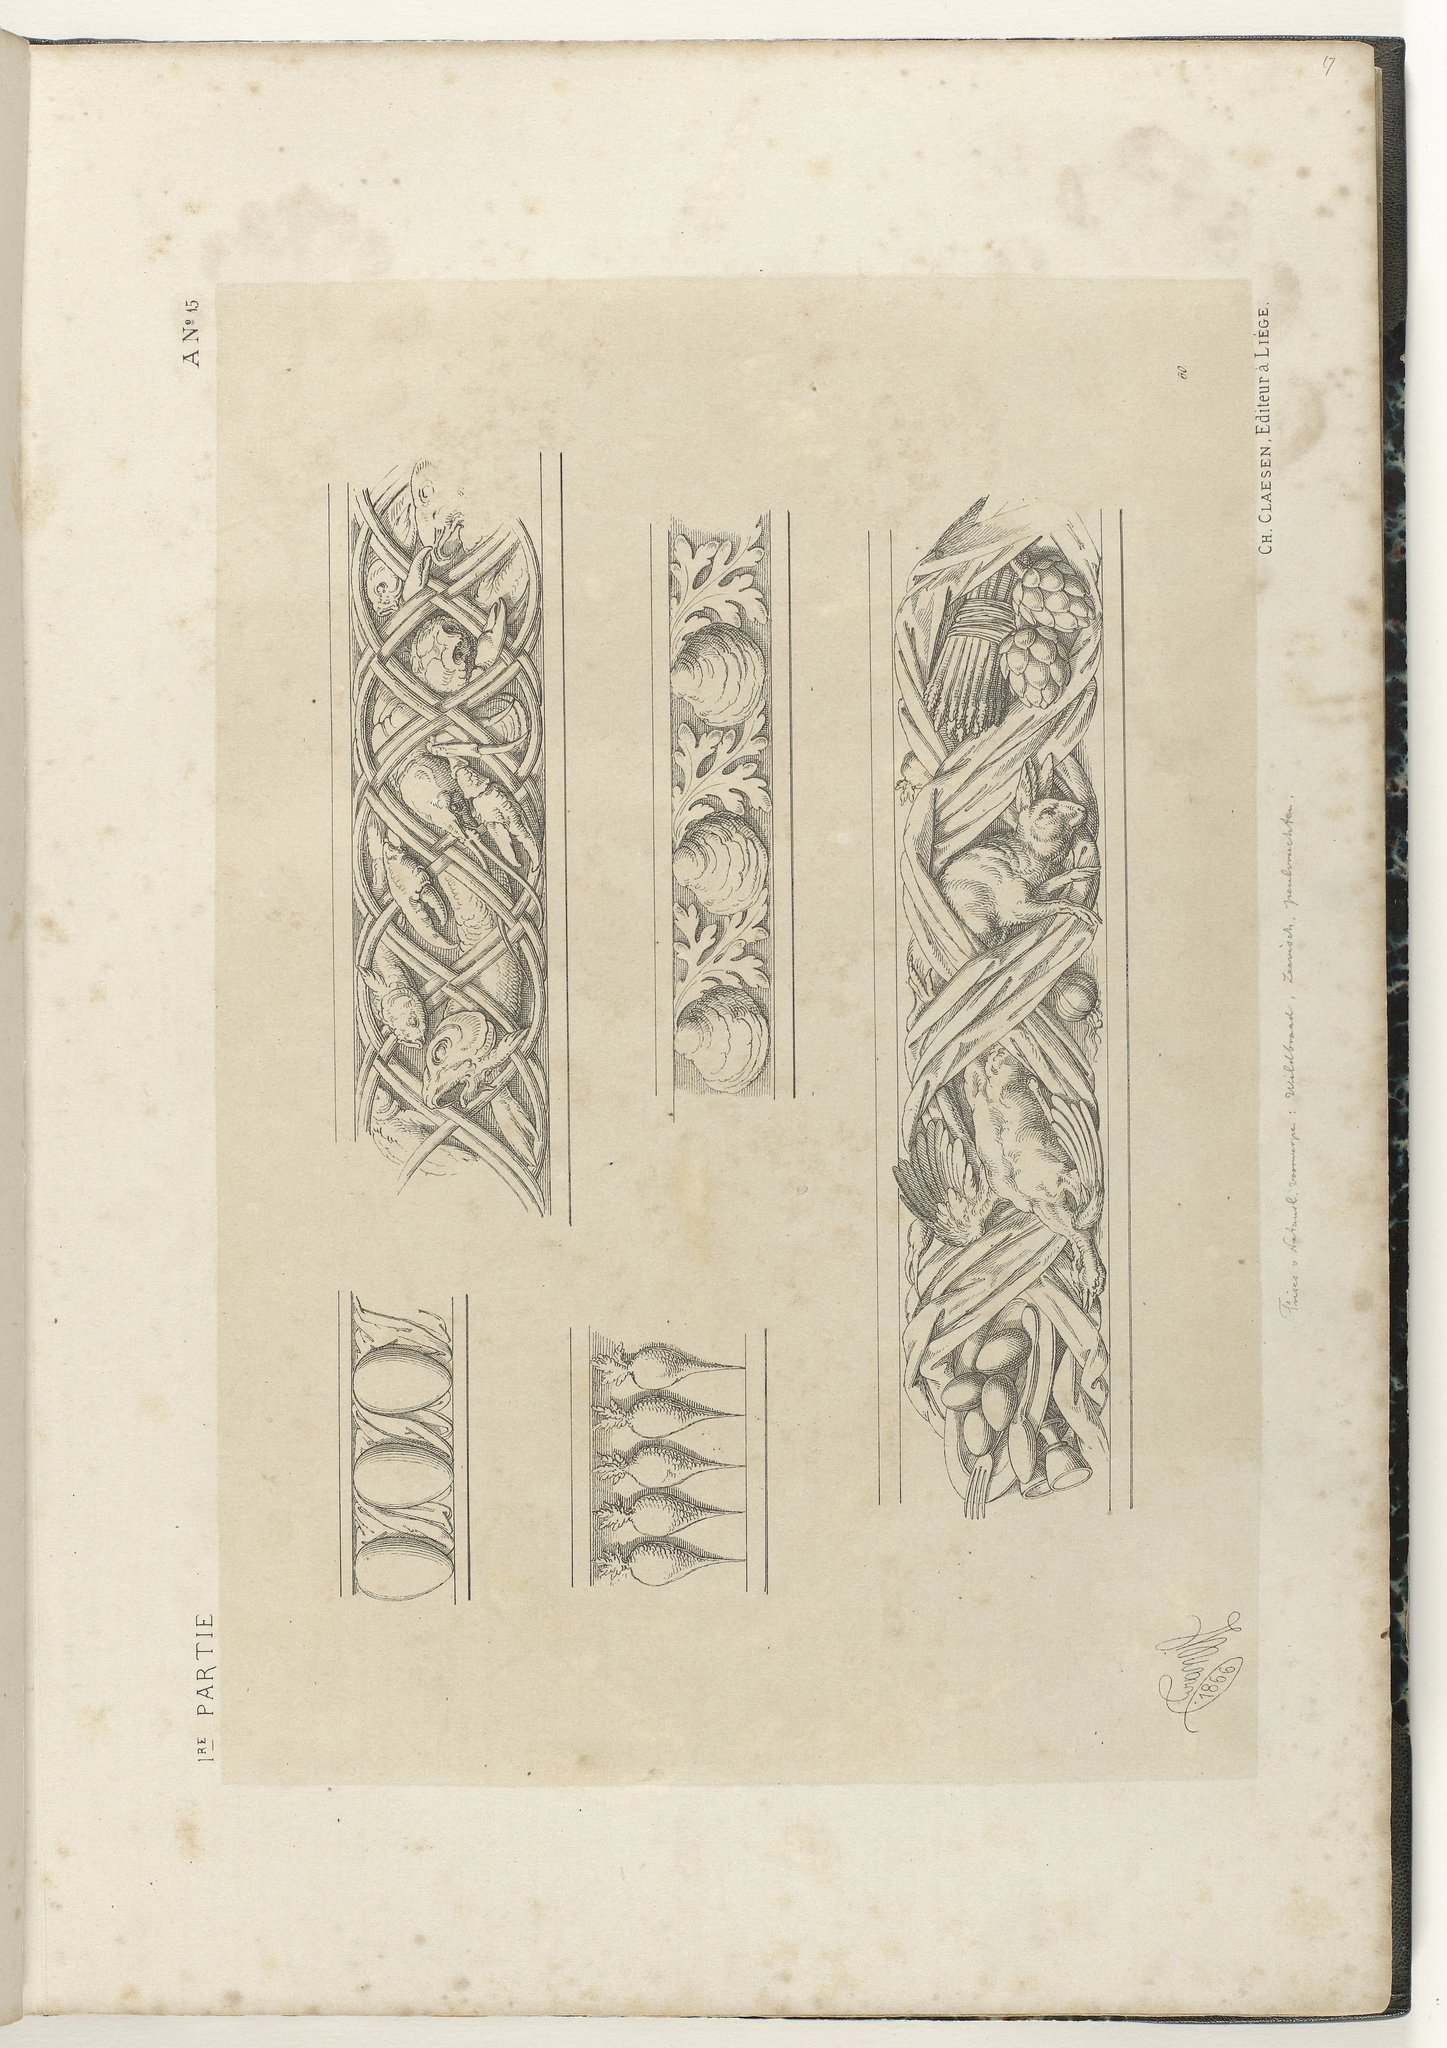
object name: print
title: Vijf friezen met eieren, zeedieren, groente en wild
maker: michel liénard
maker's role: print maker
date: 1866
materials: paper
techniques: tone lithography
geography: liège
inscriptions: annotation: ‘Frises v Natuurl. voorwerpen : Wildbraad, Zeevisch, Peulvruchten.’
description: Rechtsboven staat een fries afgebeeld met vissen, een kreeft en een krab, opgesloten in een motief van in elkaar vervlochten banden. Linksboven: 1re partie, rechtsboven: A N° 15 rechtsonder: 60.